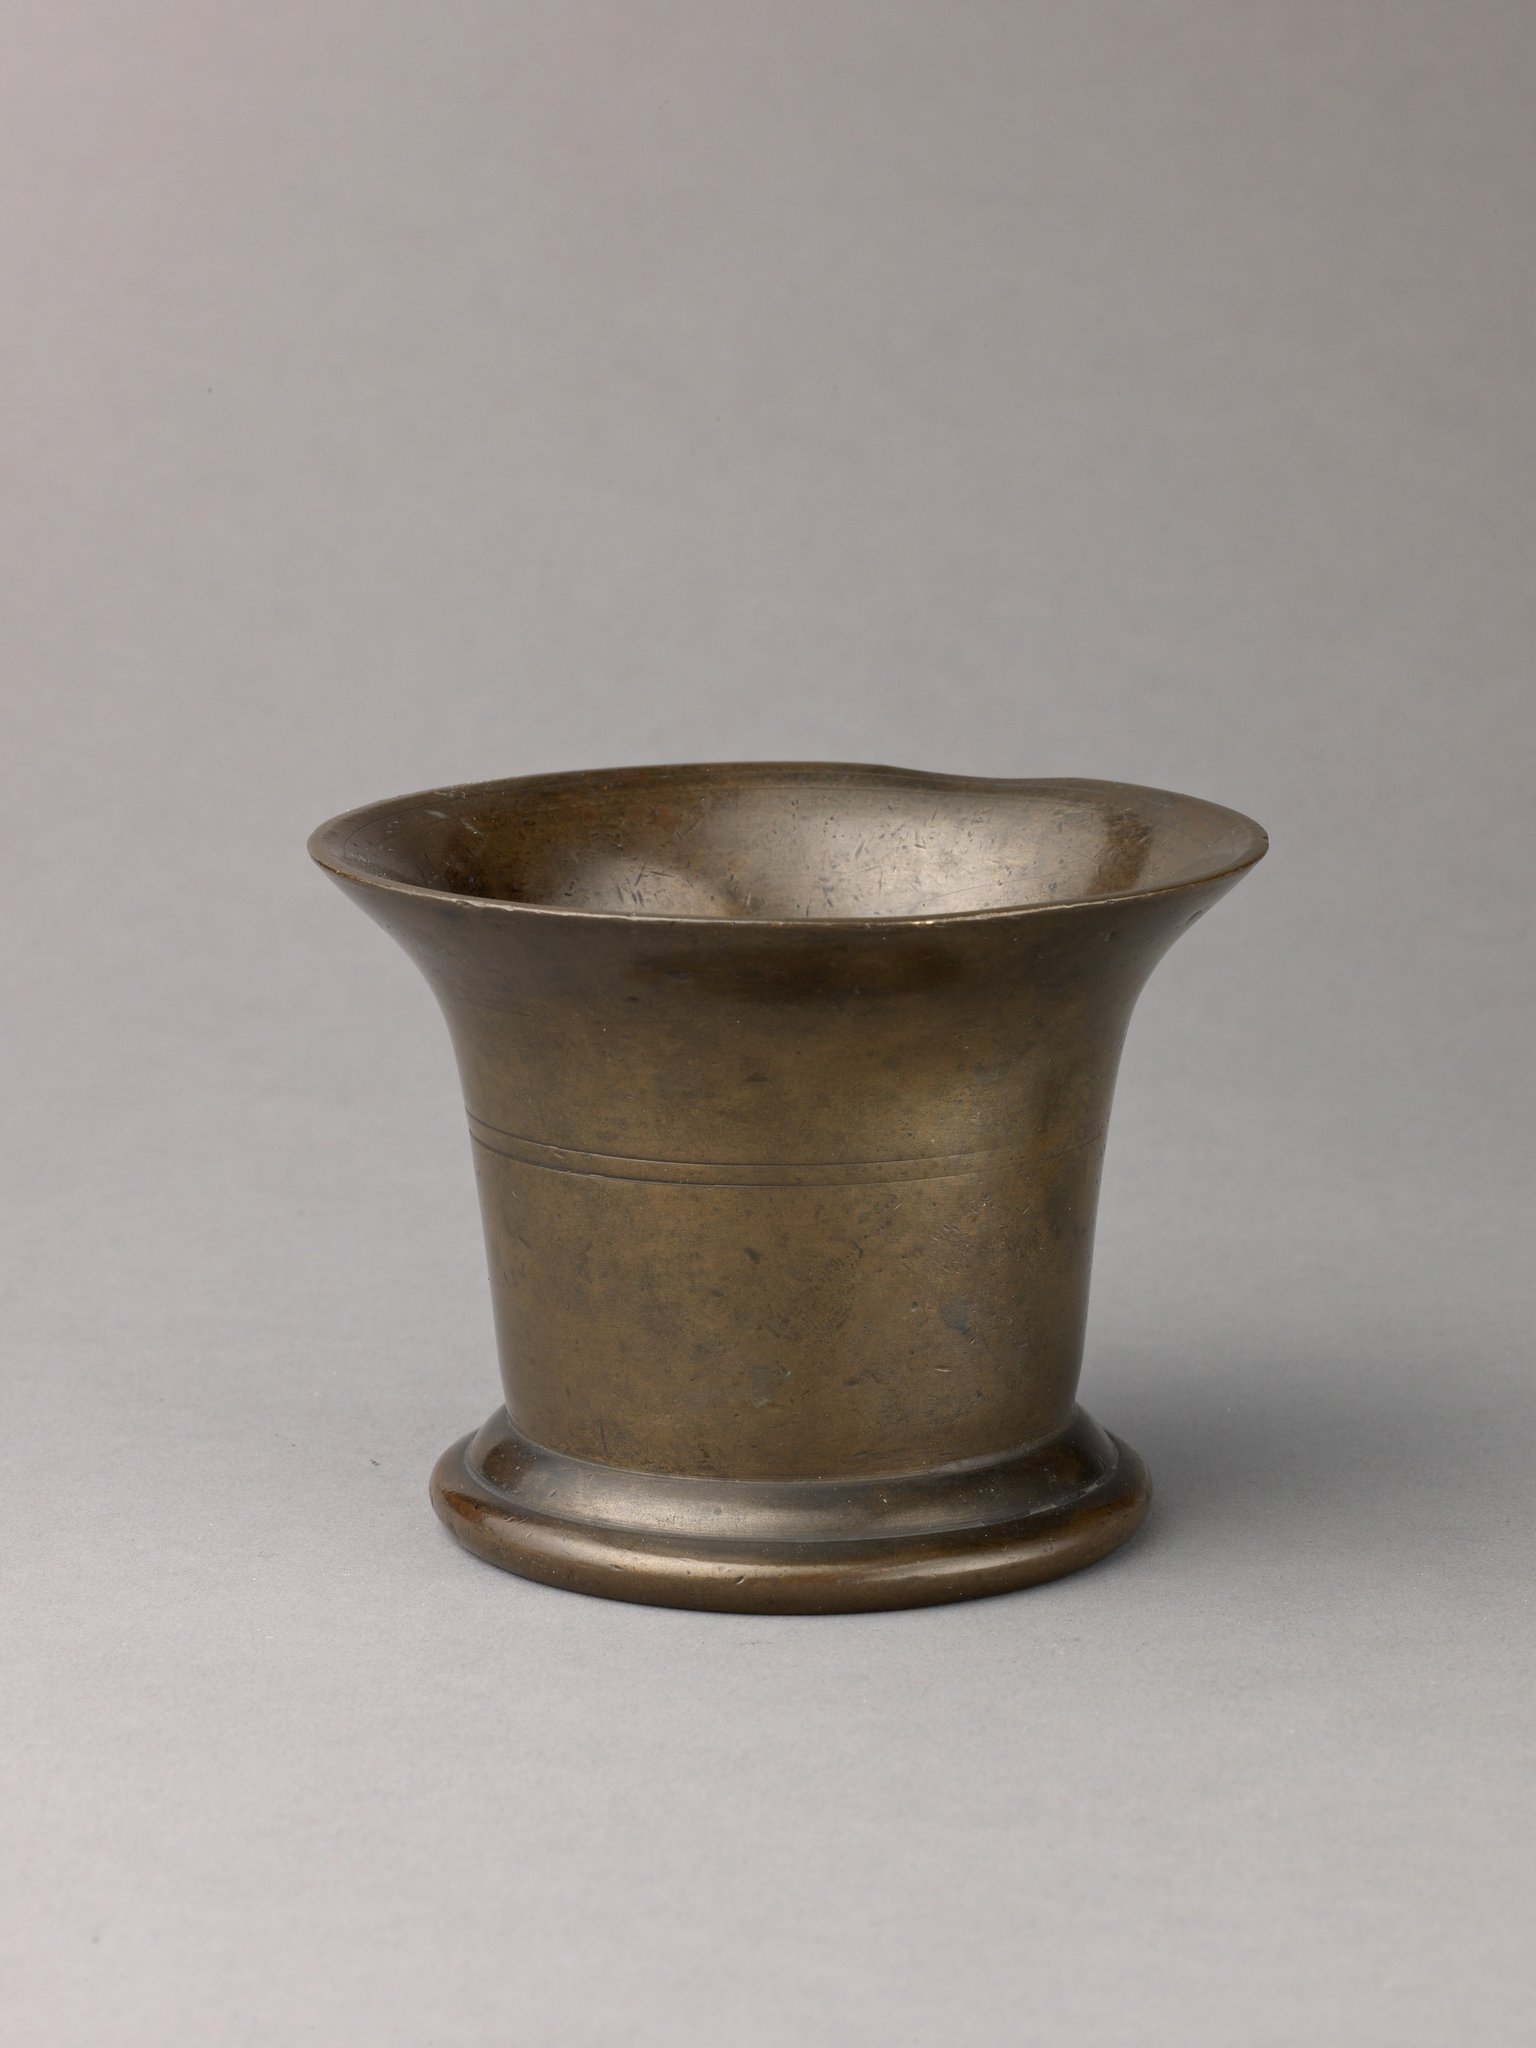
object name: mortar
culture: italian or spanish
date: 1801-1900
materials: copper alloy, patina